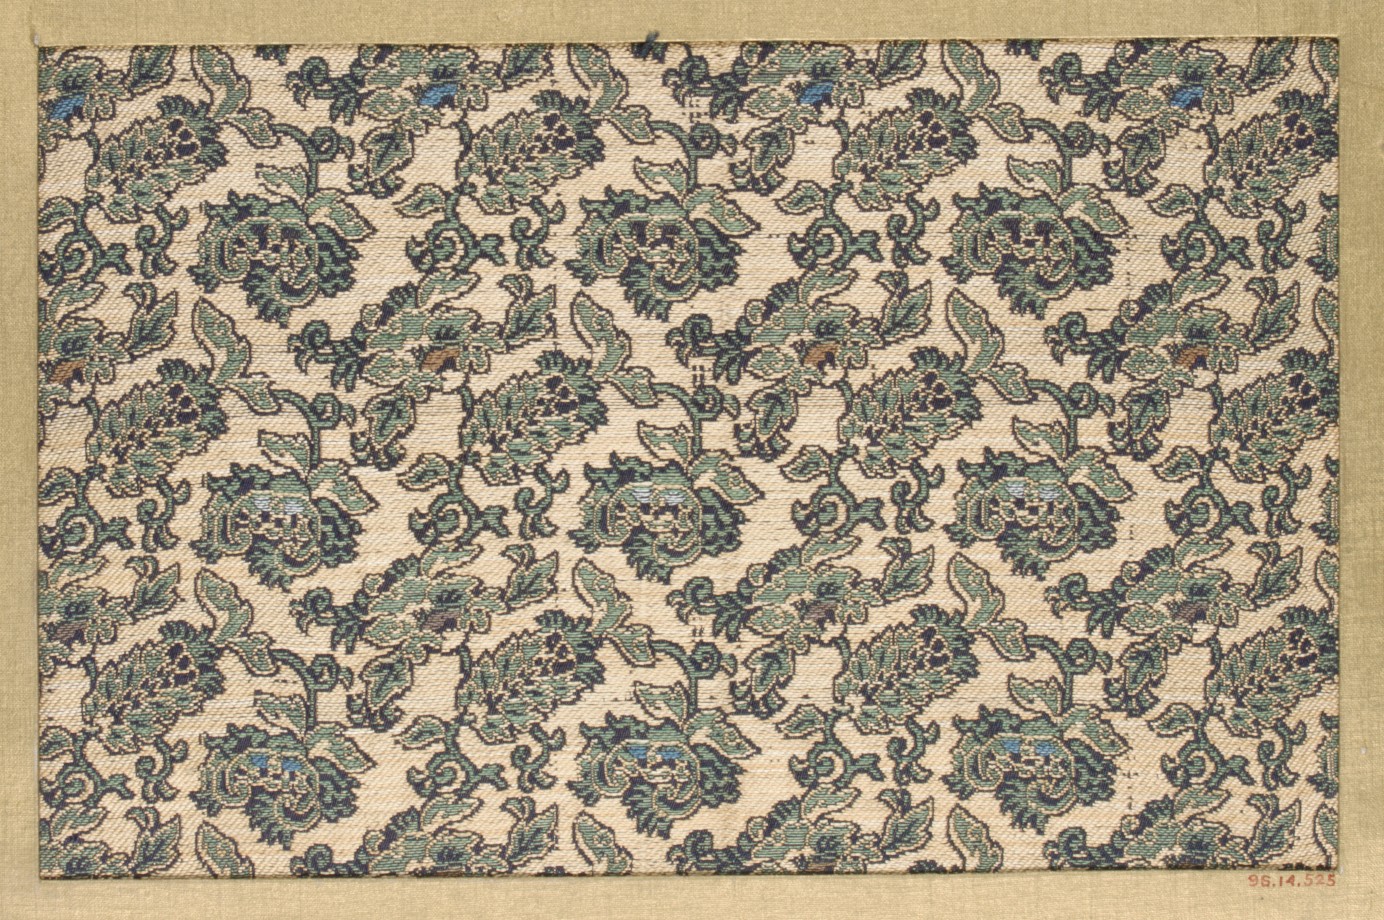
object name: piece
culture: japanese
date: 1701-1900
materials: silk